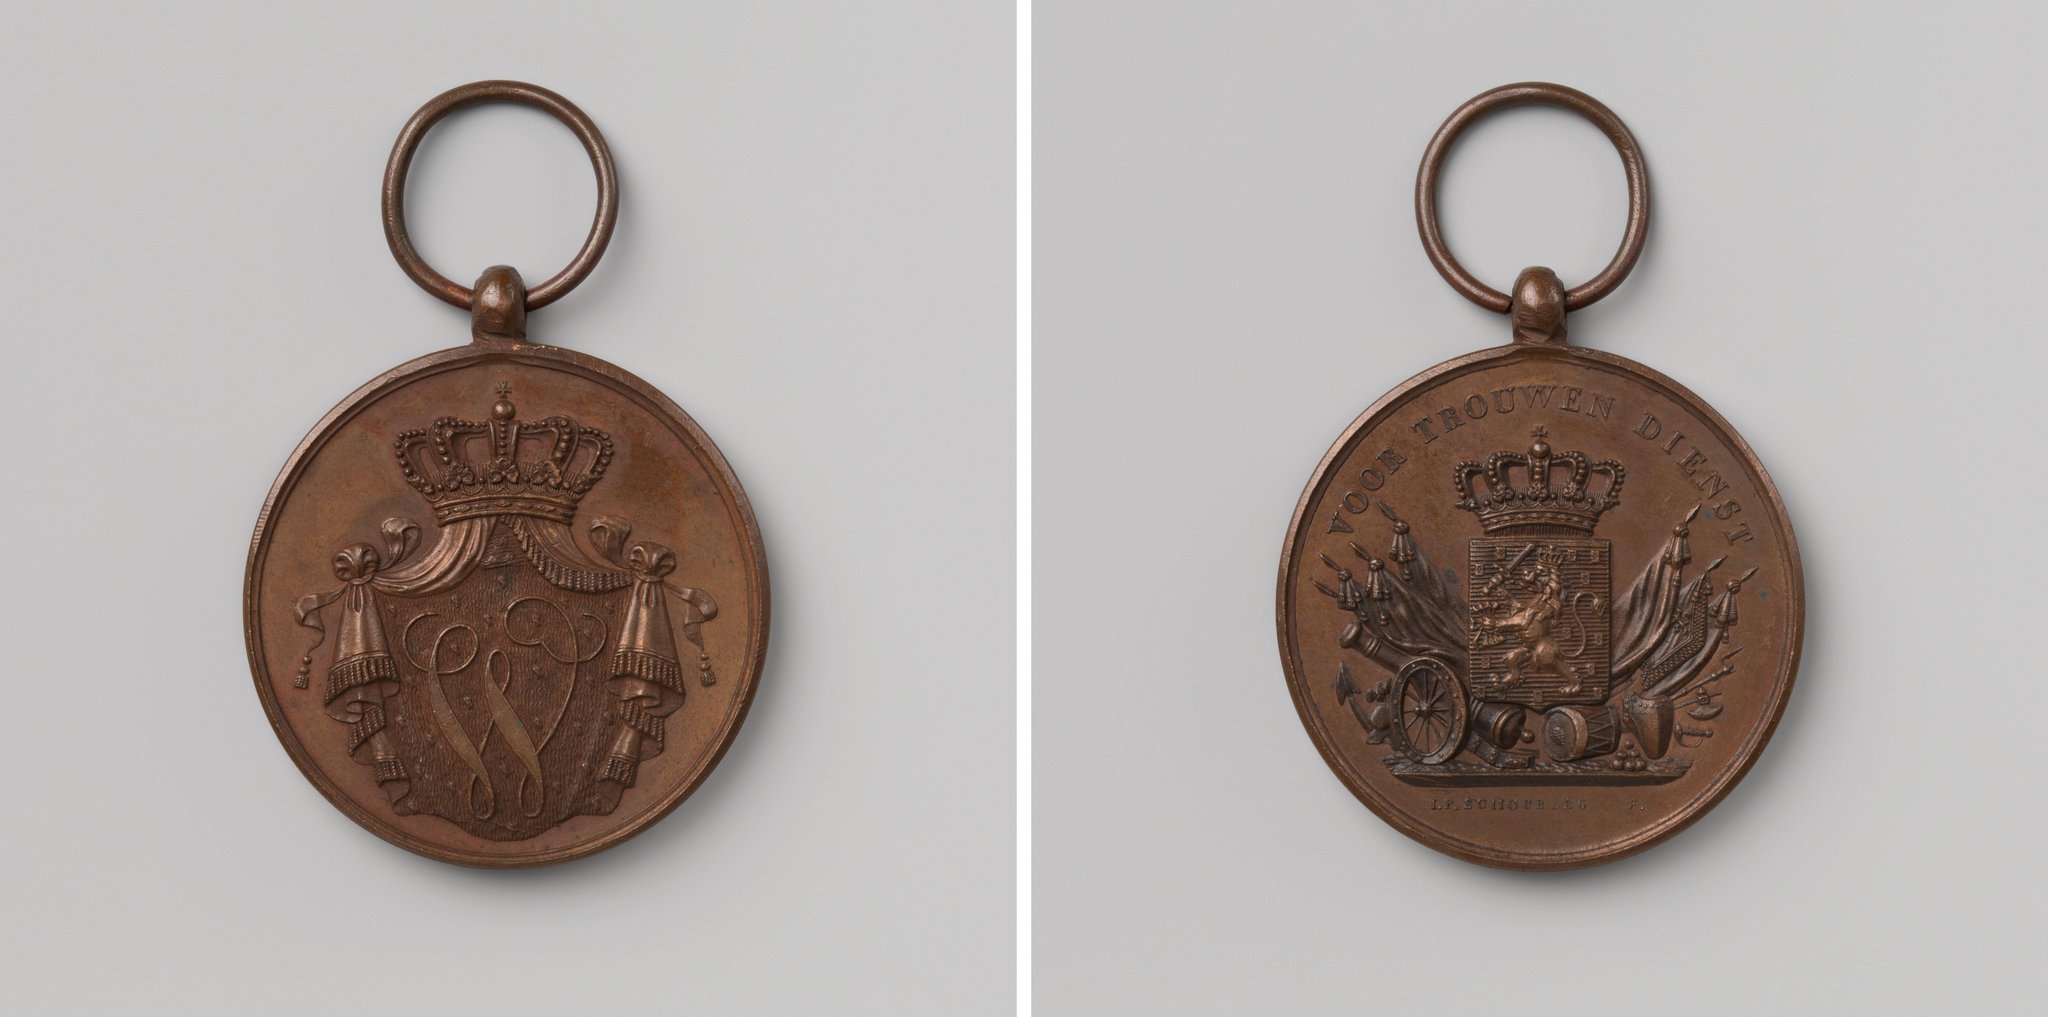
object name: insignia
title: Trouwen dienst bij de landmacht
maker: johannis petrus schouberg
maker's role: die cutter, draughtsman, print maker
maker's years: 1798-1864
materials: bronze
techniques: striking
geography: utrecht